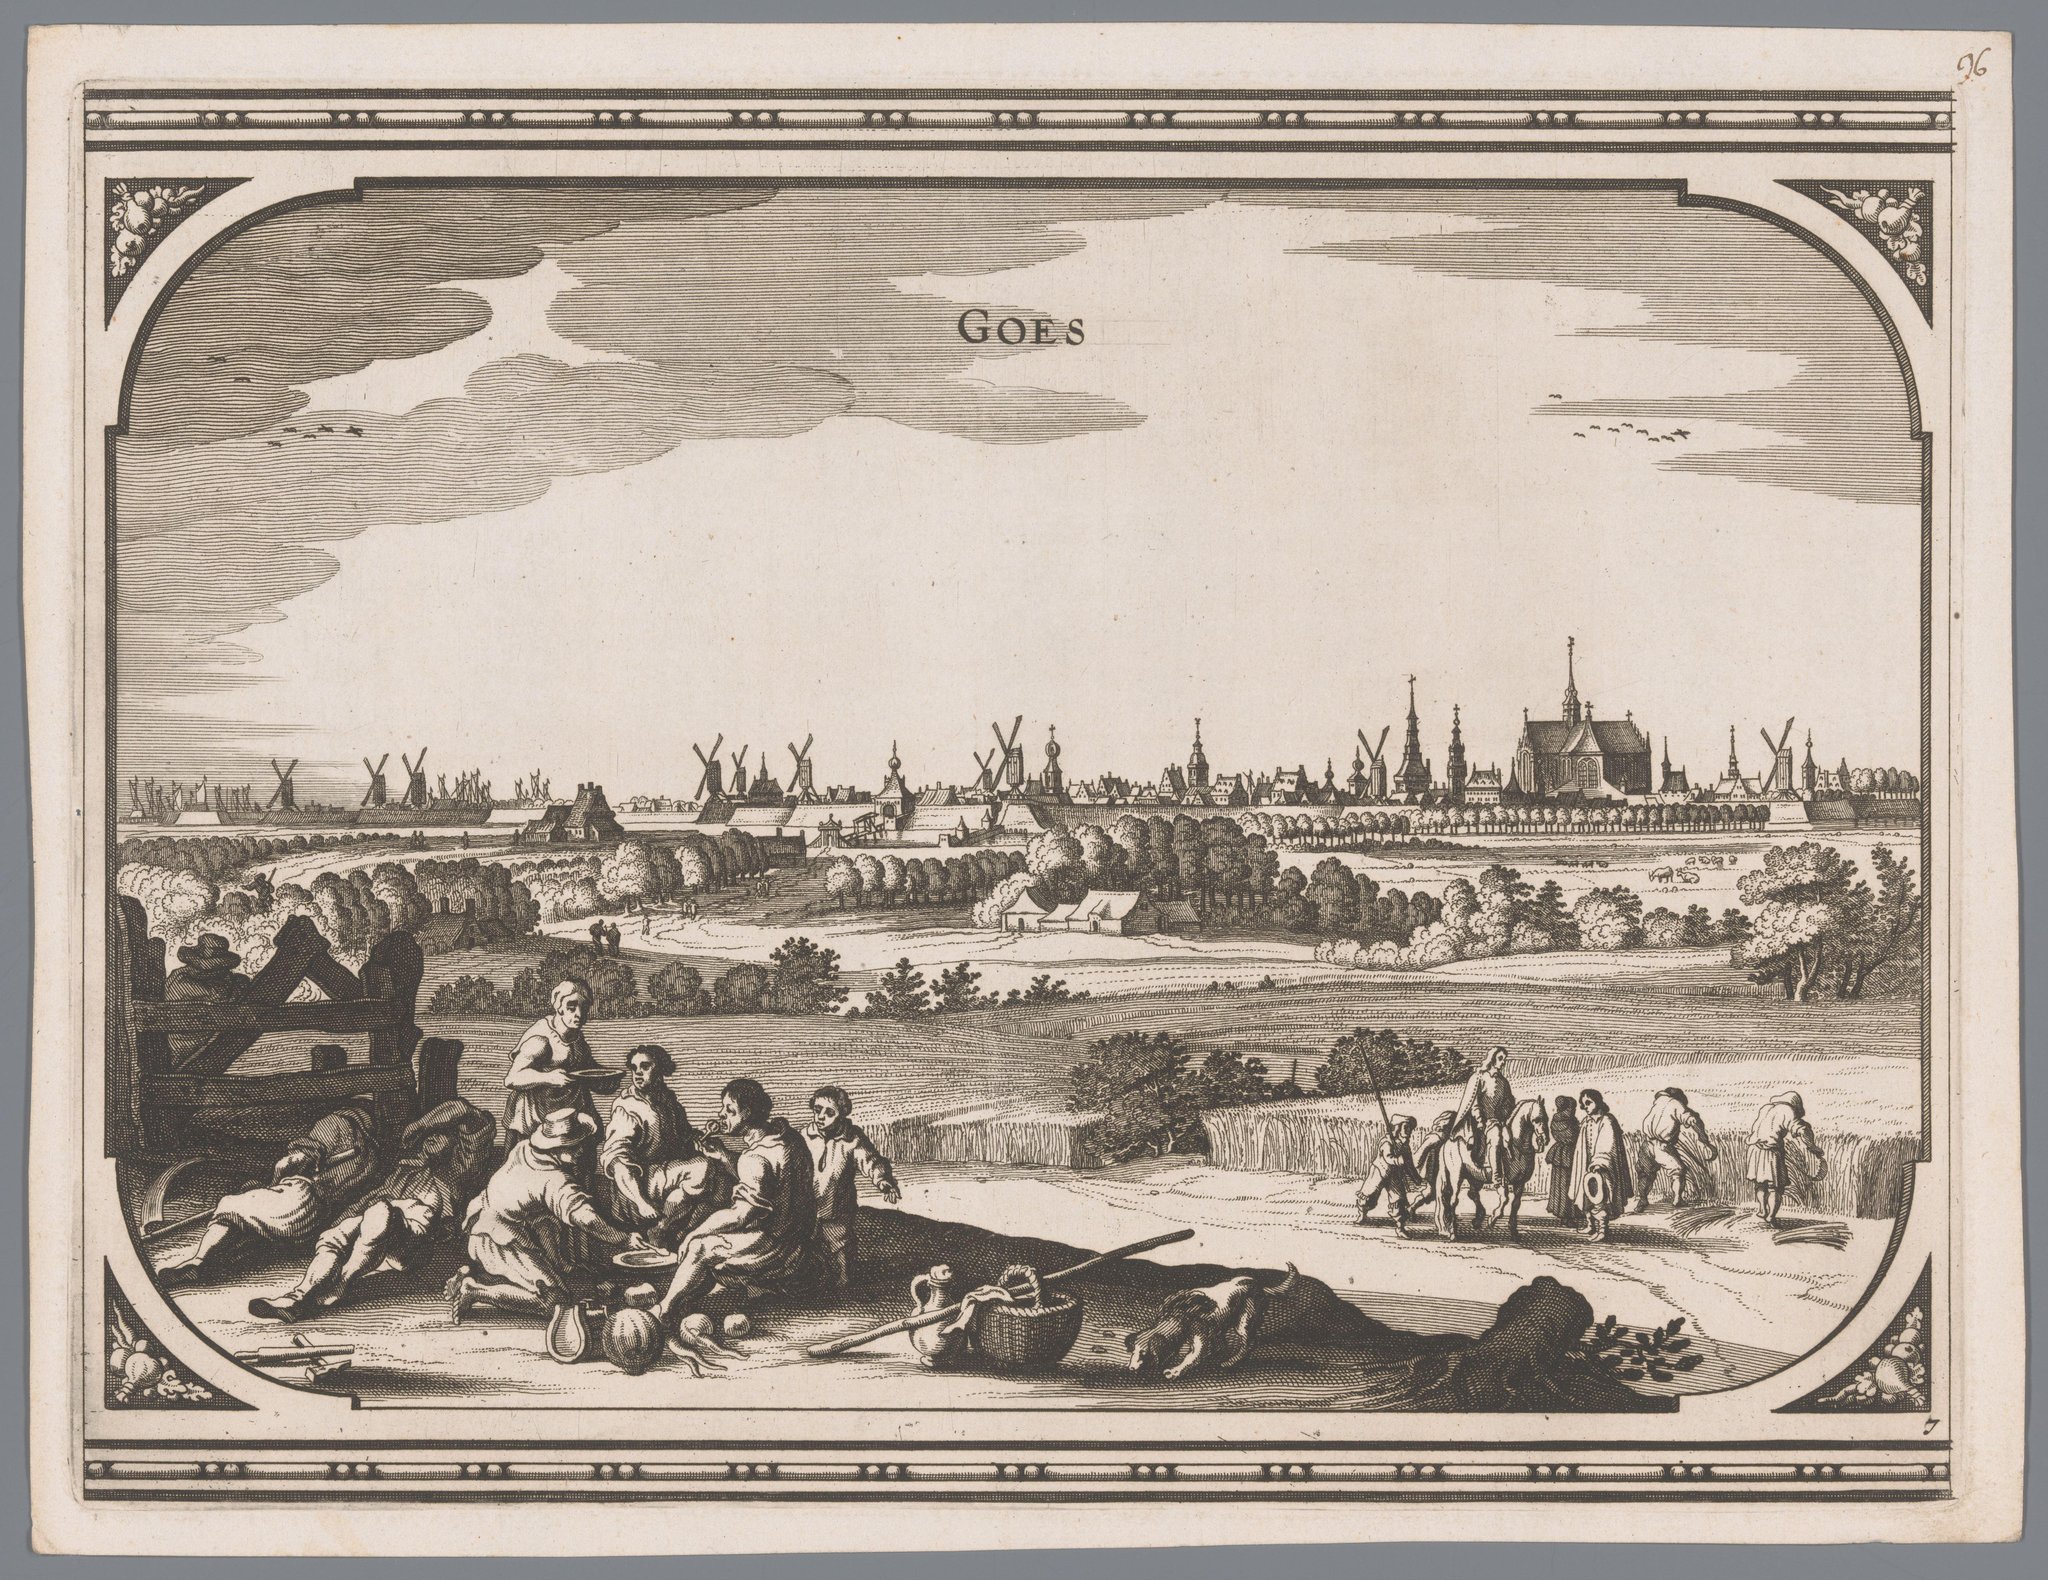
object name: print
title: Goes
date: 1657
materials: paper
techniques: etching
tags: prospect of village, silhouette of village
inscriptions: inscription: ‘96’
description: Prent verschenen in: Theatrum praecipuarum urbium ducatus Brababtiae necnon comitatum Flandriae et Zelandiae. Amsterdam: Nicolaes Visscher, 1657. Verschillende staten van prenten zijn gebruikt in andere uitgaven van 'Speculum Zelandiae' en in andere publicaties uitgegeven door Zacharias Roman en Nicolaes Visscher (I). Verwarring rondom de datering kan ontstaan door het feit dat de prenten uit 'Speculum Zelandiae' ook voorkomen in eerder uitgegeven publicaties, waar ze later in zijn ingebonden. Zo komen prenten uitgegeven door Roman/Visscher voor in sommige exemplaren van: Boxhorn, Marcus Zuerius van. Chroniick van Zeelandt (…). 2 dln. Middelburg: Zacharias Roman, 1644. De door weduwe (Joachim) Ottens en Zoonen uitgegeven prenten zijn later ingebonden in sommige exemplaren van: Smallegange, Mattheus. Nieuwe Cronyk van Zeeland (…). Middelburg en Amsterdam: Johannes Meertens en Abraham van Someren, 1696.